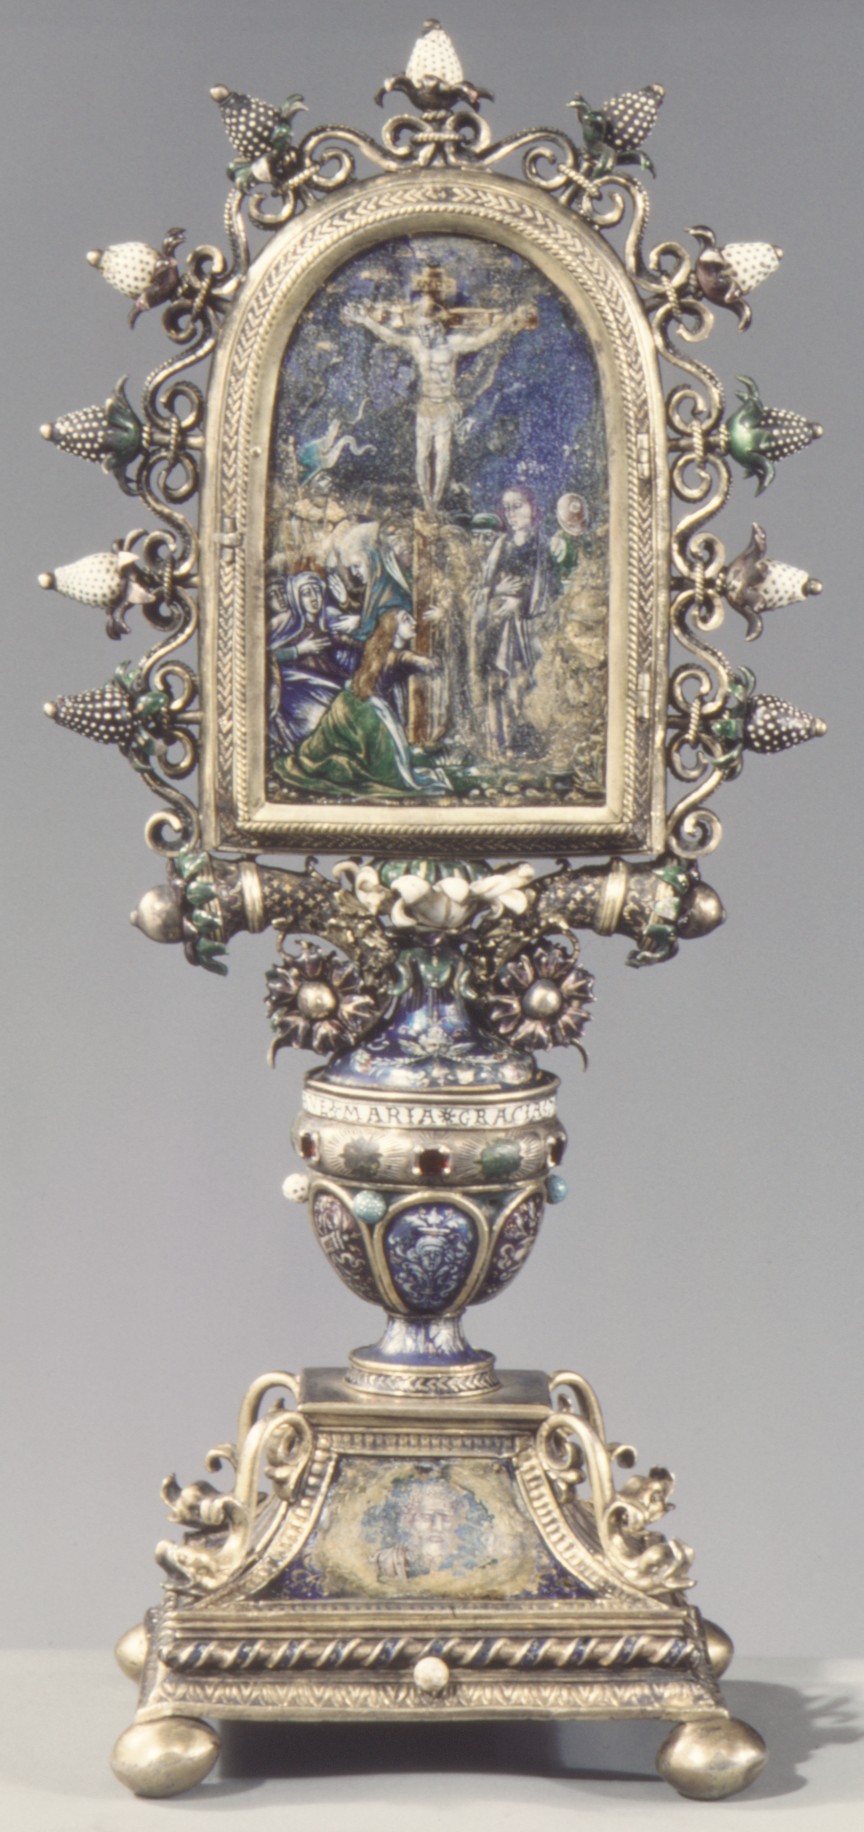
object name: tabernacle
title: Crucifixion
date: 1467-1533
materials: enamel, pearl, gemstone, silver, silver gilt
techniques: painting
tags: christ,cross,jesus,crucifixion